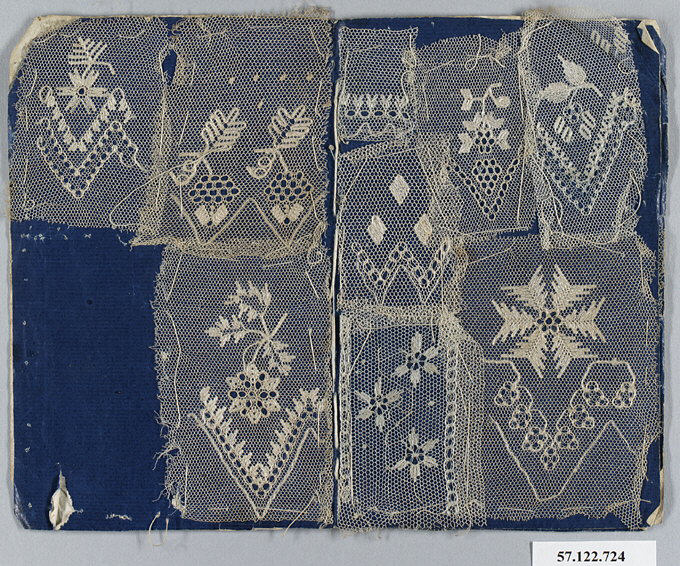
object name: sampler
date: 1801-1900